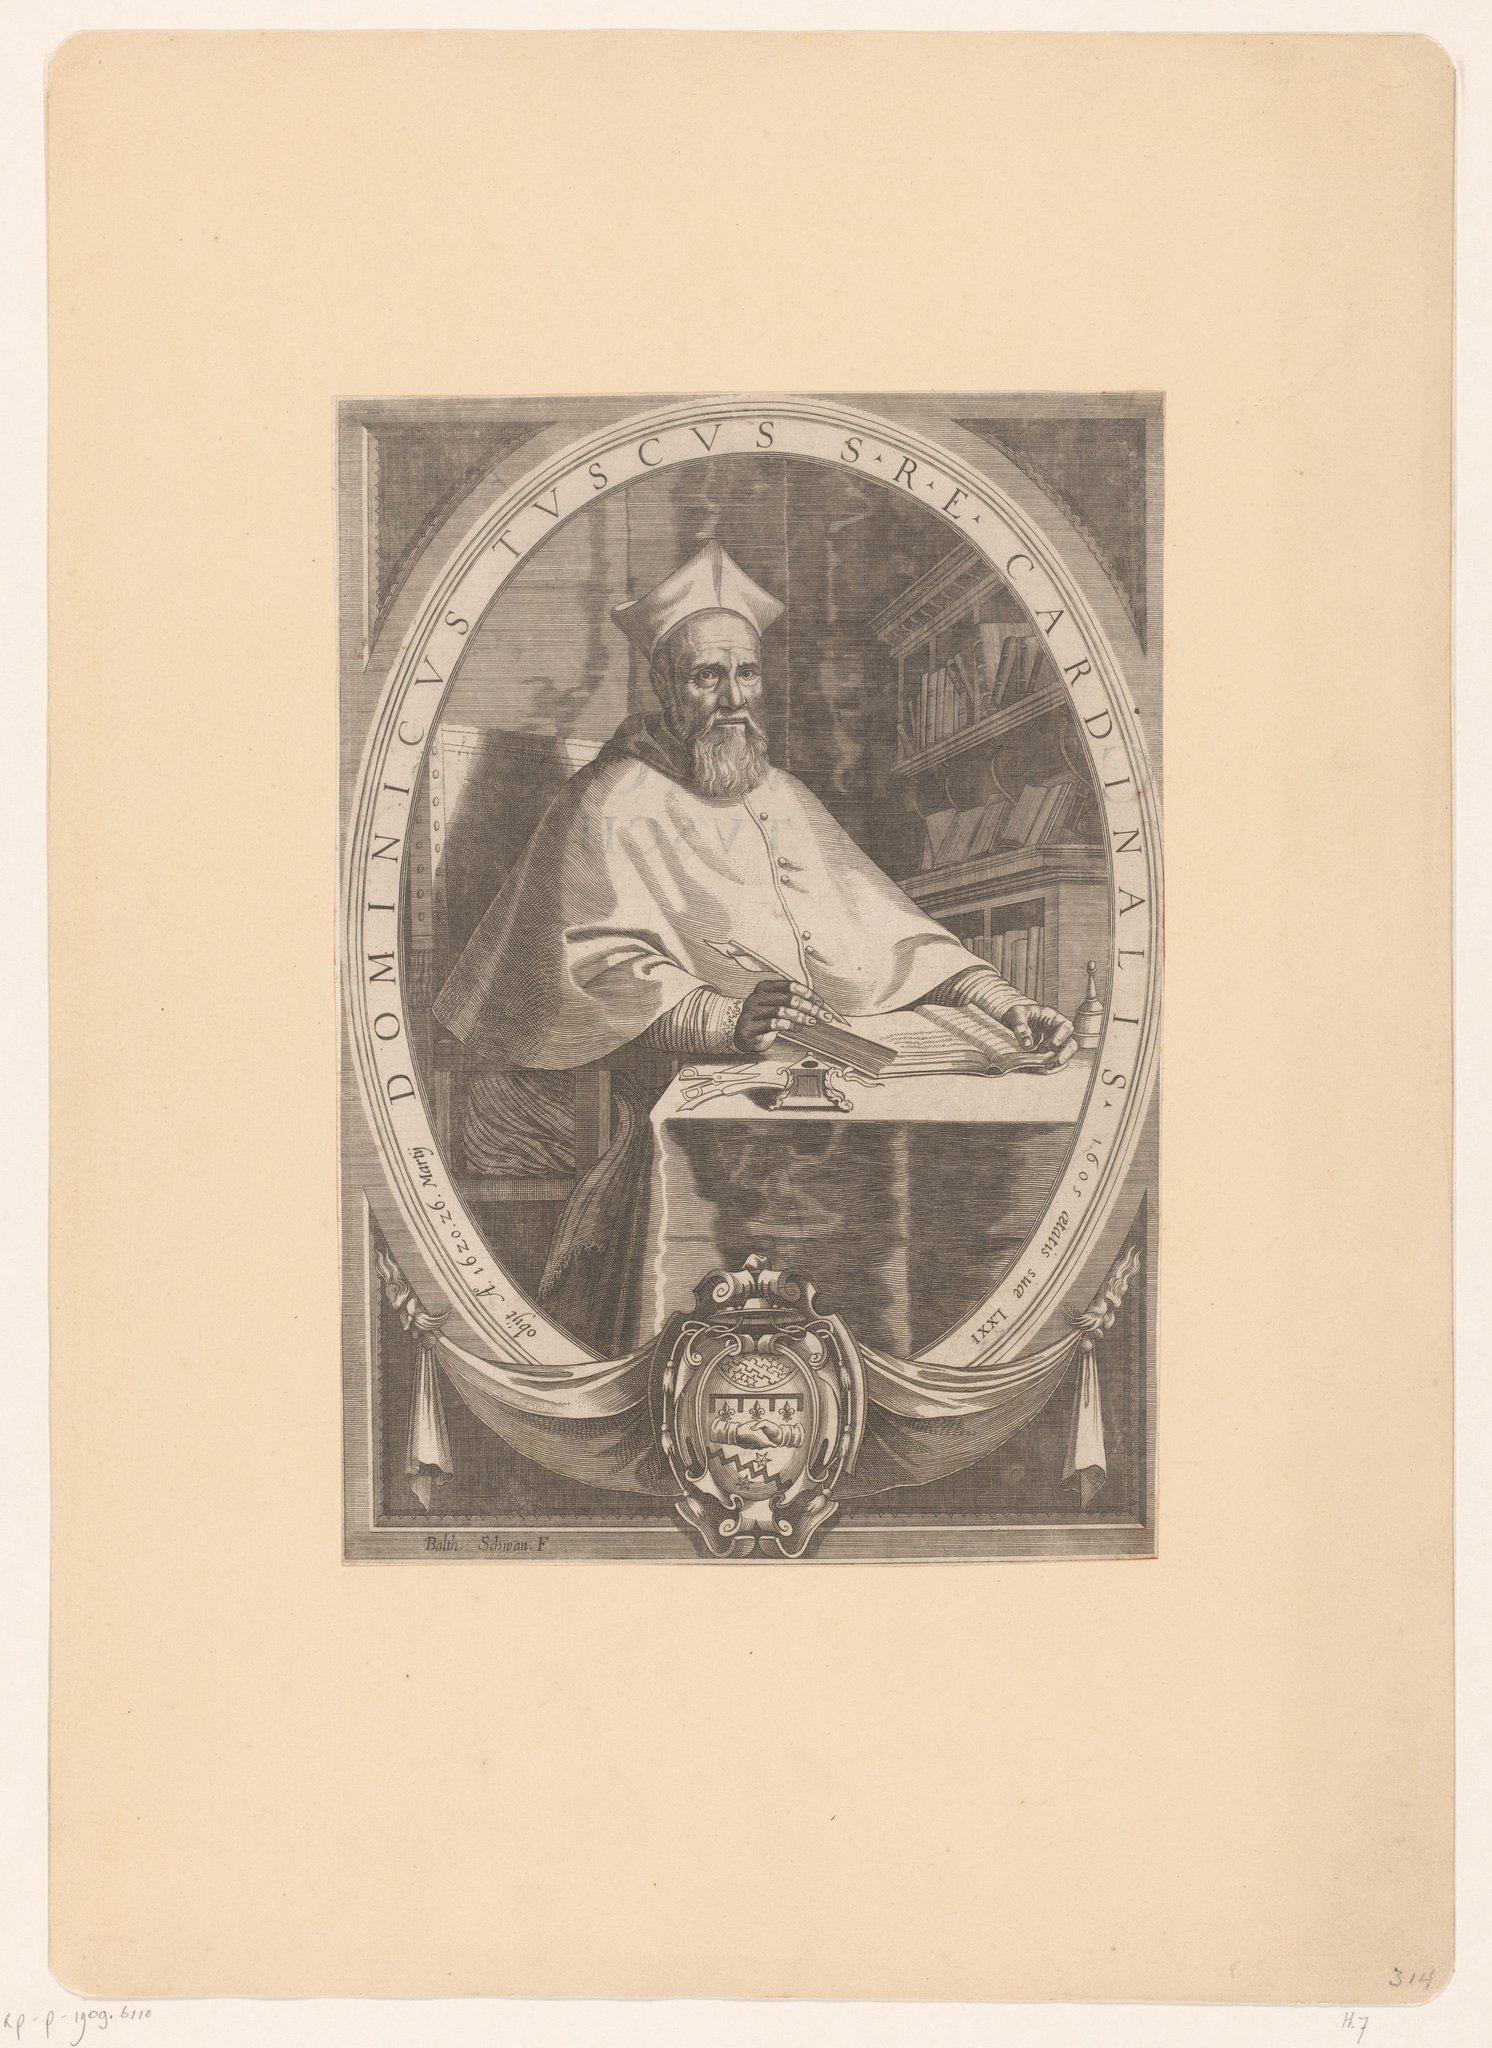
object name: print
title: Portret van Domenico Toschi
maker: balthasar schwan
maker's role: print maker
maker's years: -1624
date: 1620-1624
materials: paper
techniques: etching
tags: rome, historical persons, armorial bearing, heraldry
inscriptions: collector's mark: Lugt 2228